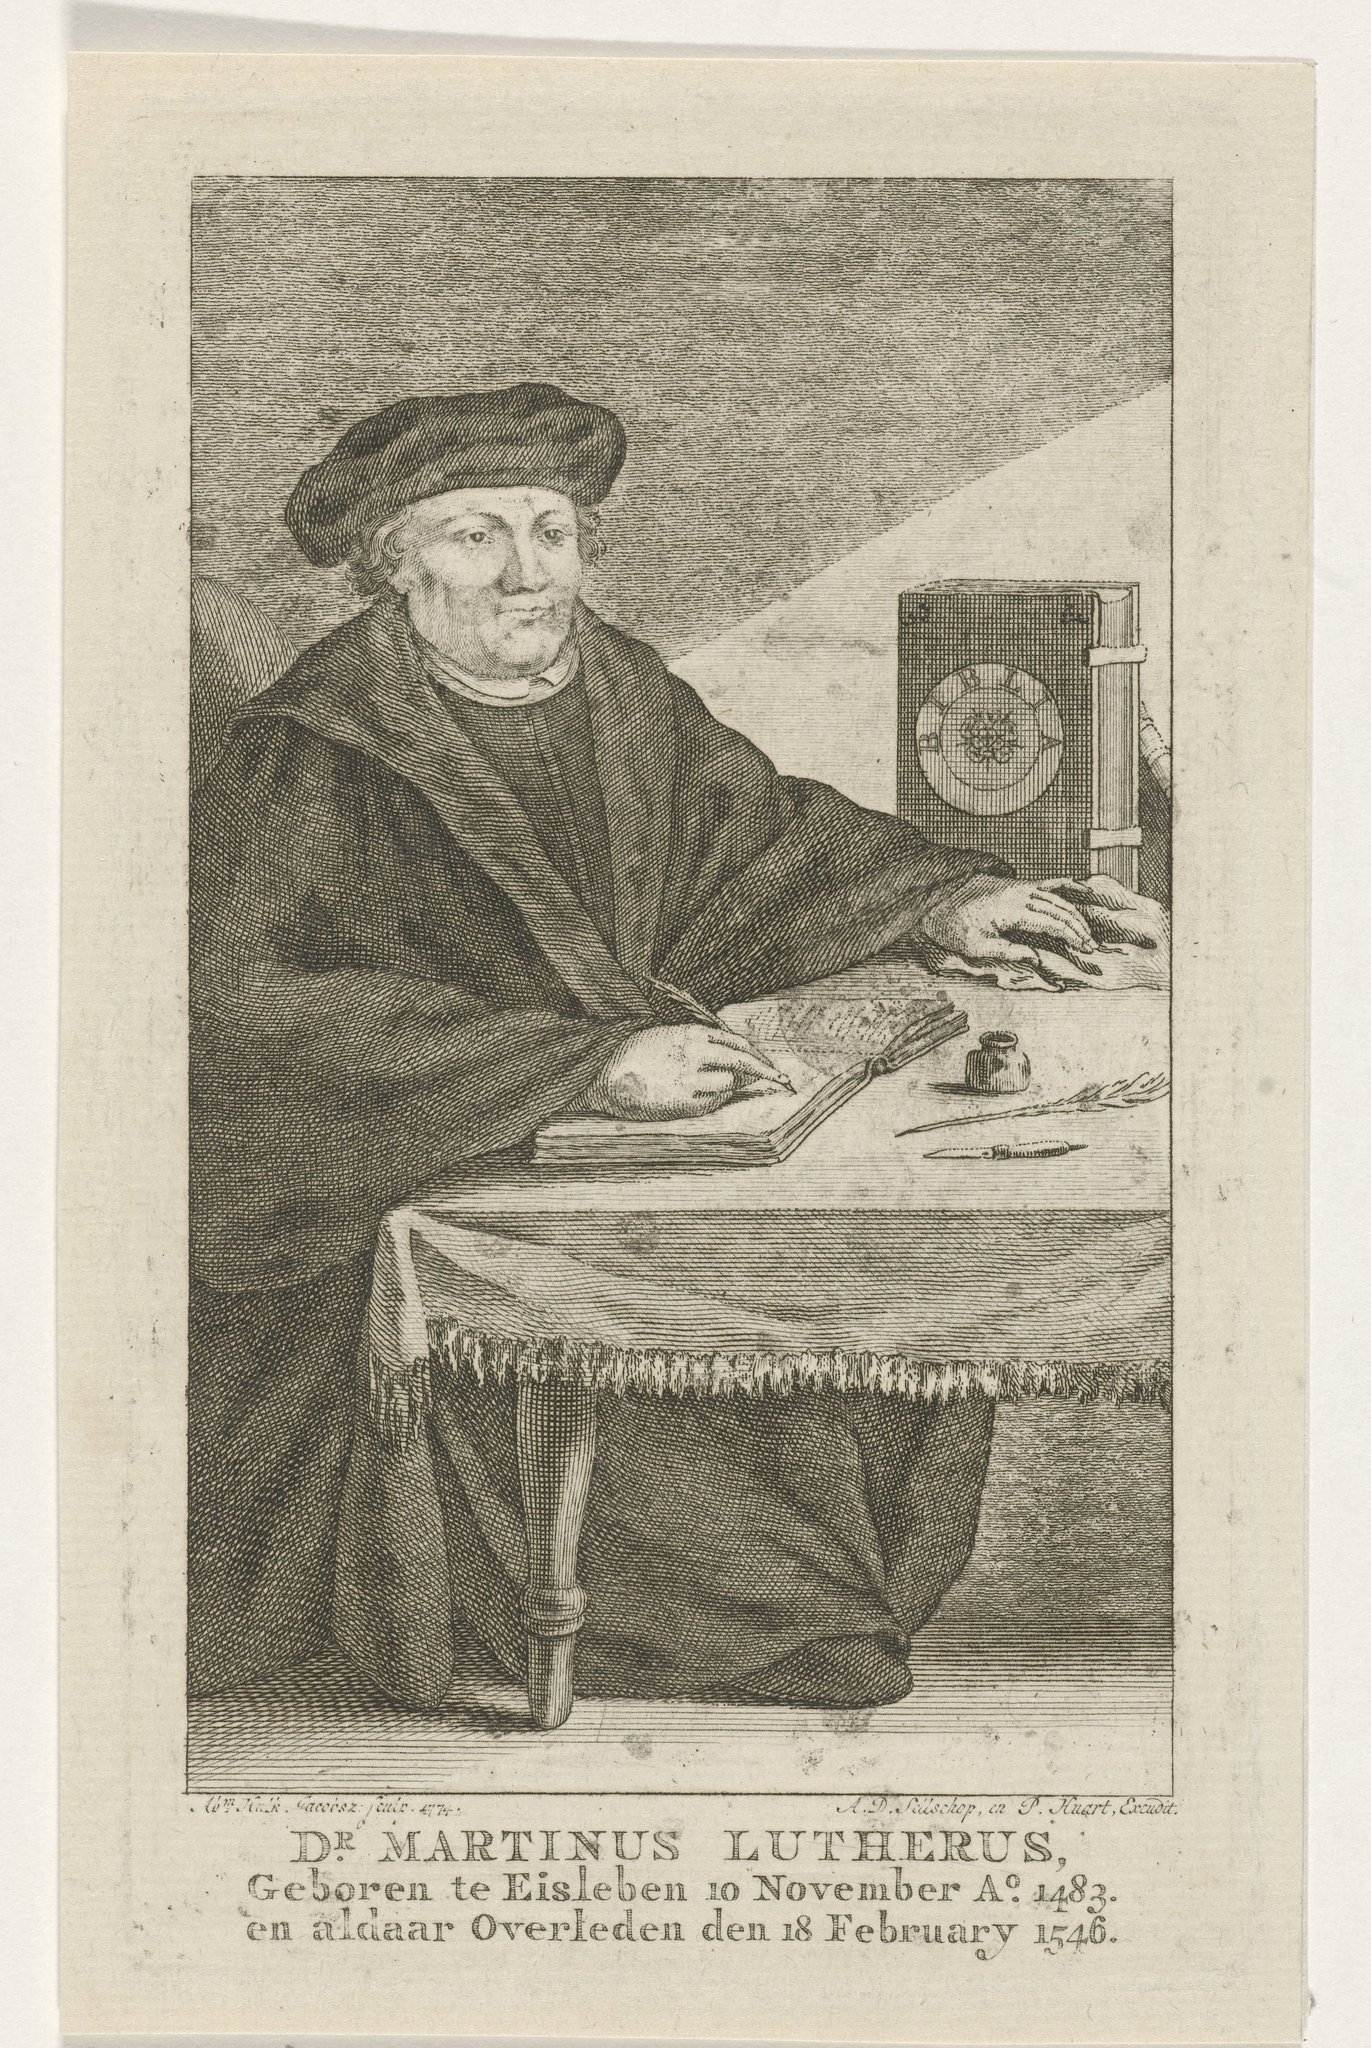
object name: print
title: Portret van Martin Luther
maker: abraham jacobsz. hulk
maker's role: print maker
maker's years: 1751-1817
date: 1774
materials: paper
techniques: engraving, etching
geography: amsterdam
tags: priest, martin luther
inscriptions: collector's mark: Lugt 2228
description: Portret naar rechts ten voeten uit van Martin Luther, zittende en schrijvende aan een tafel. Op de tafel een rechtop staande Bijbel, een inktpot, veer en een pennenmes. Onder drie tekstregels in het Nederlands.